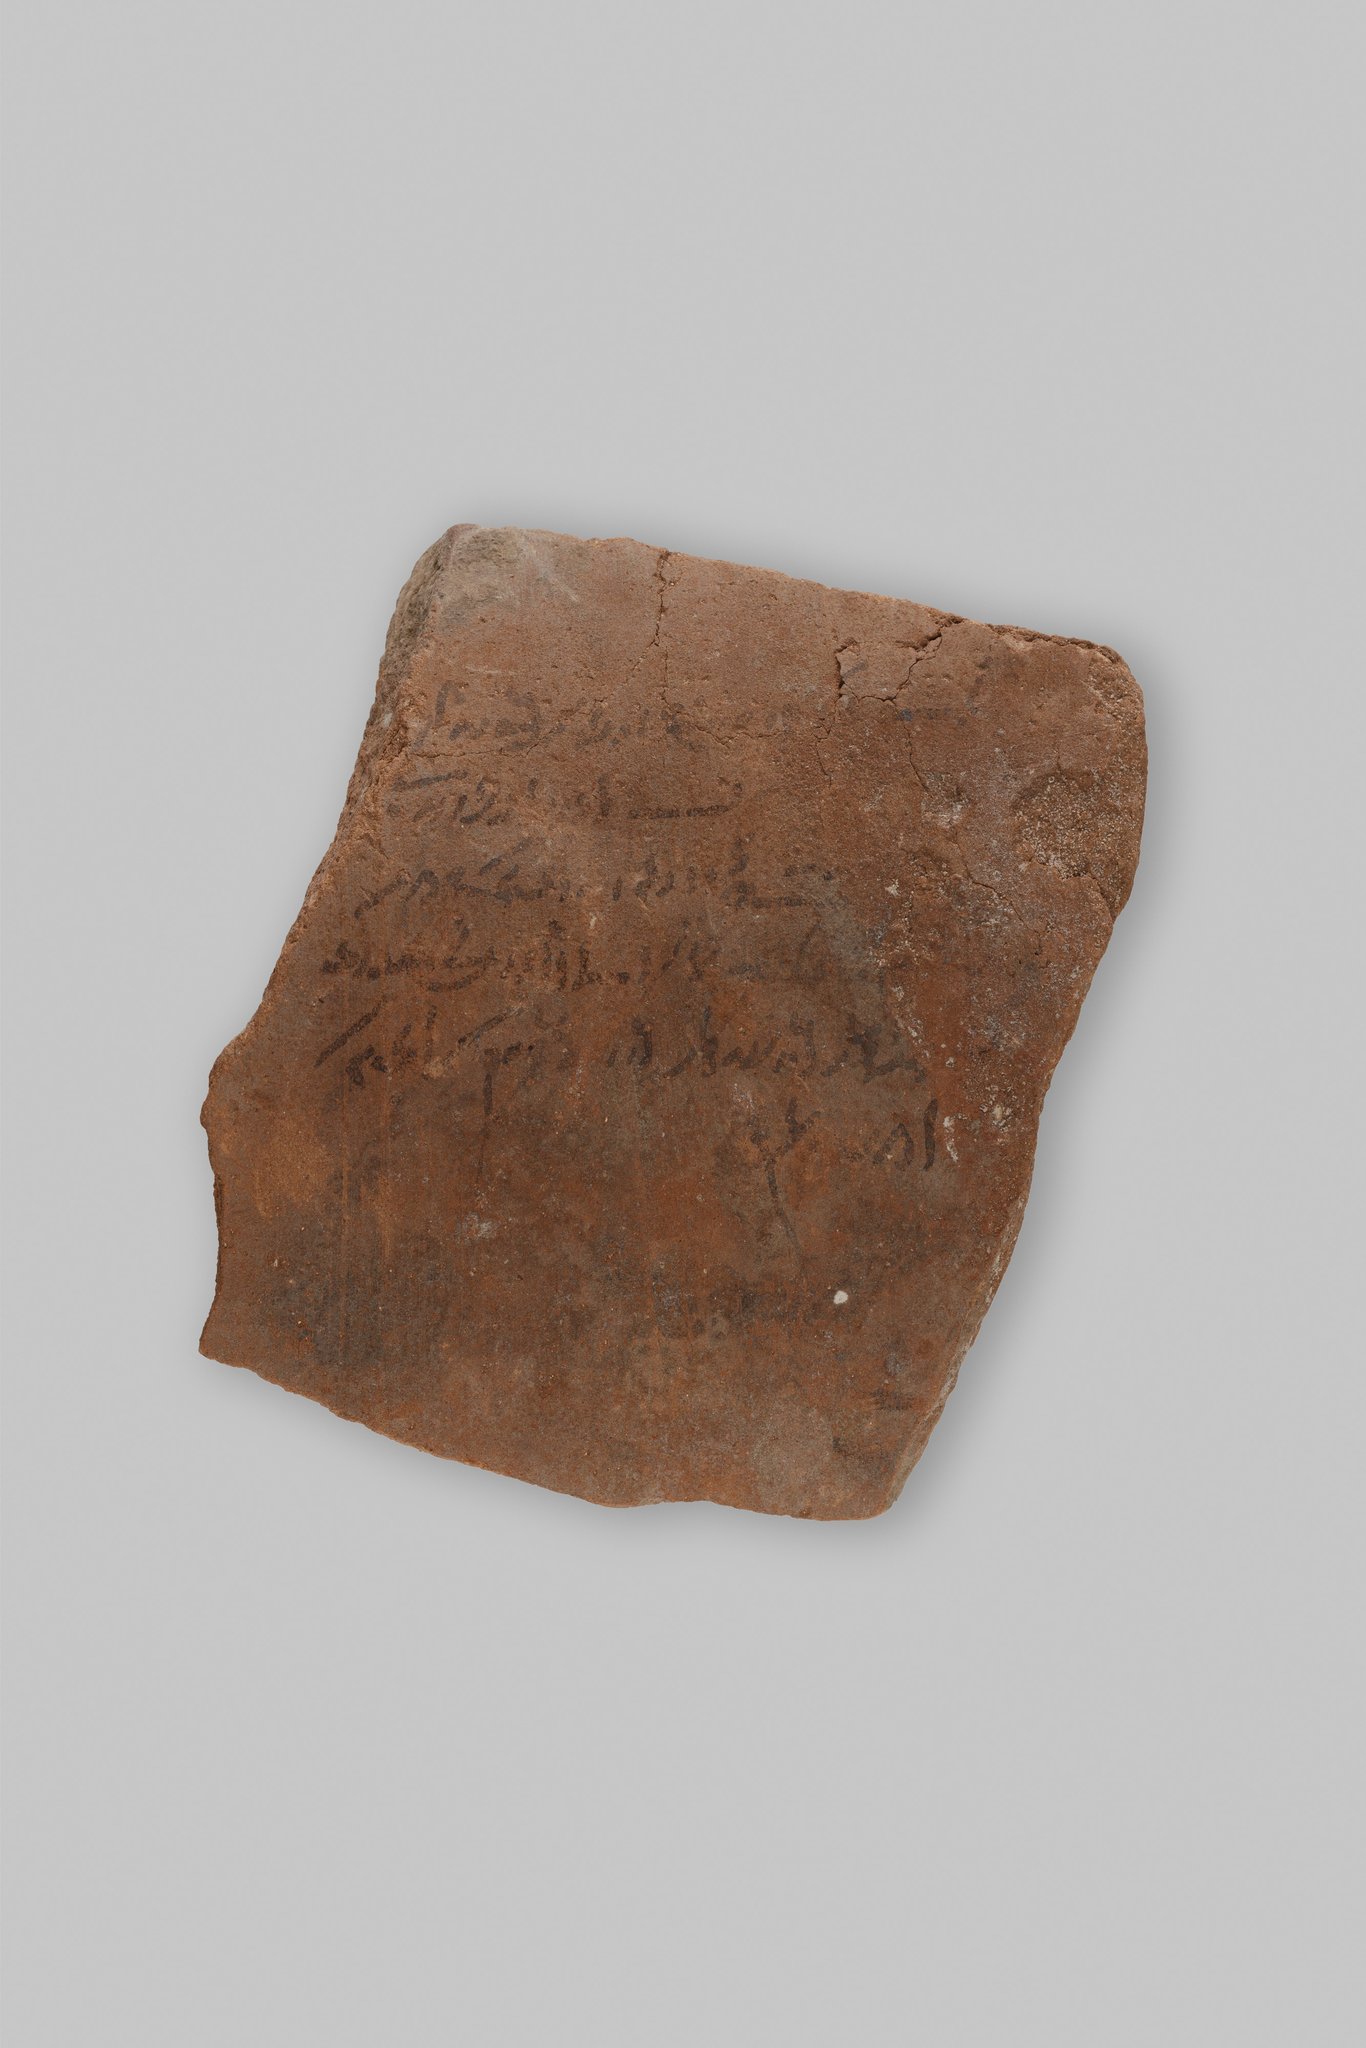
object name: ostracon, tax receipt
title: Ostracon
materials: ink, pottery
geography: egypt